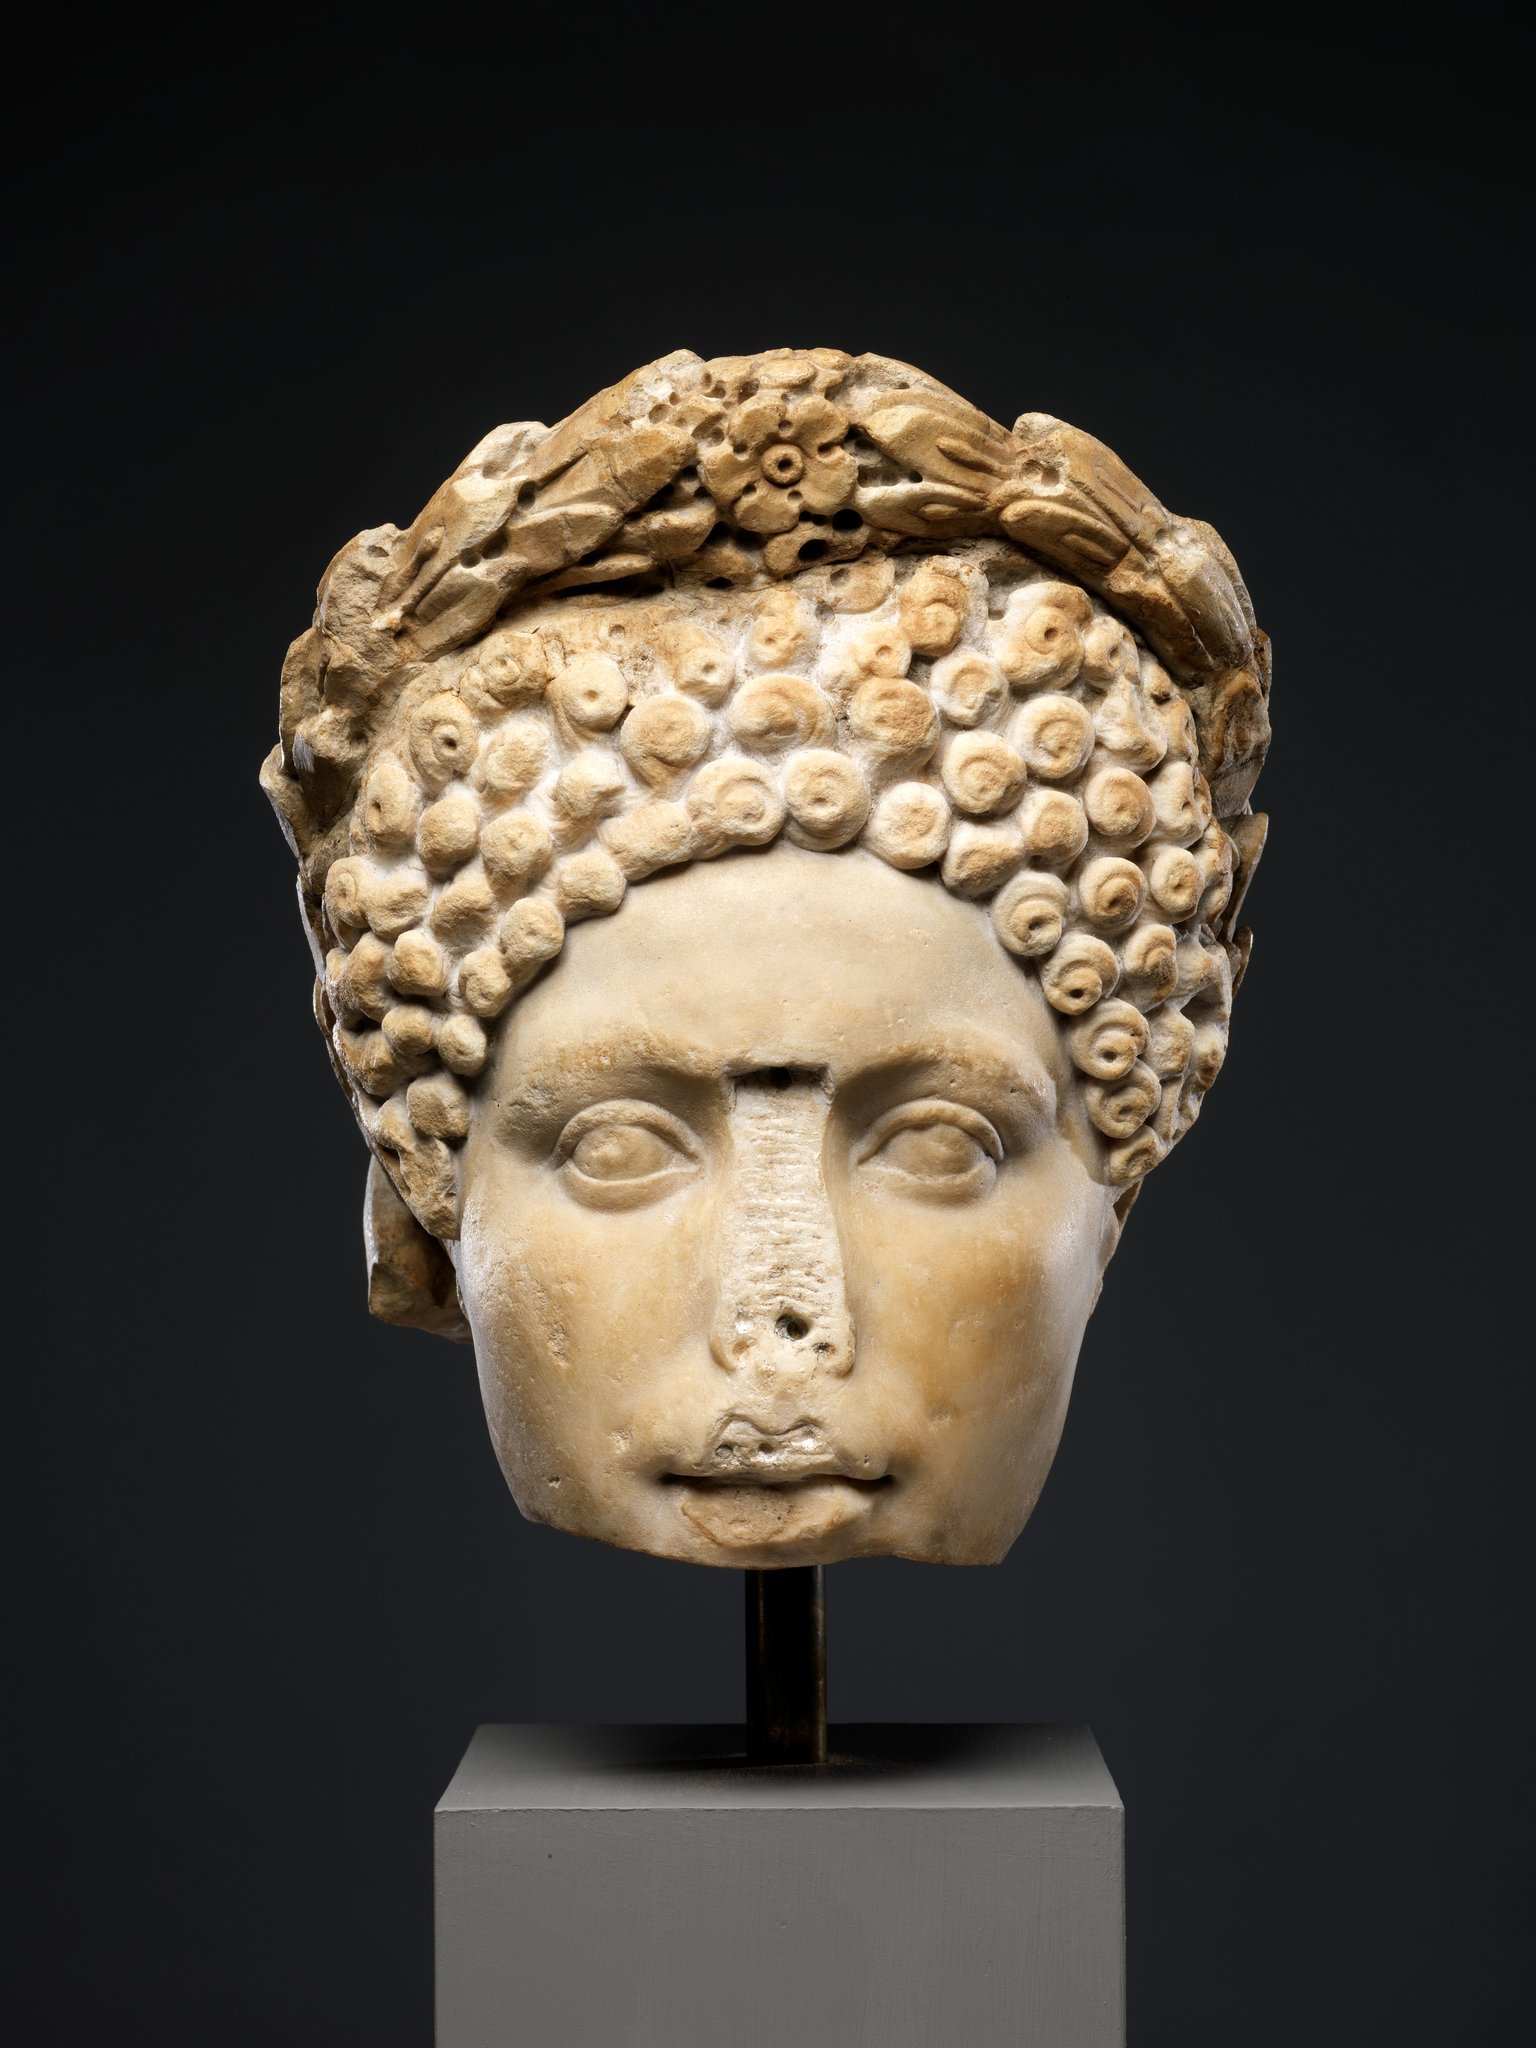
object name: portrait head of a woman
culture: roman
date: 80-100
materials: marble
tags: heads,women